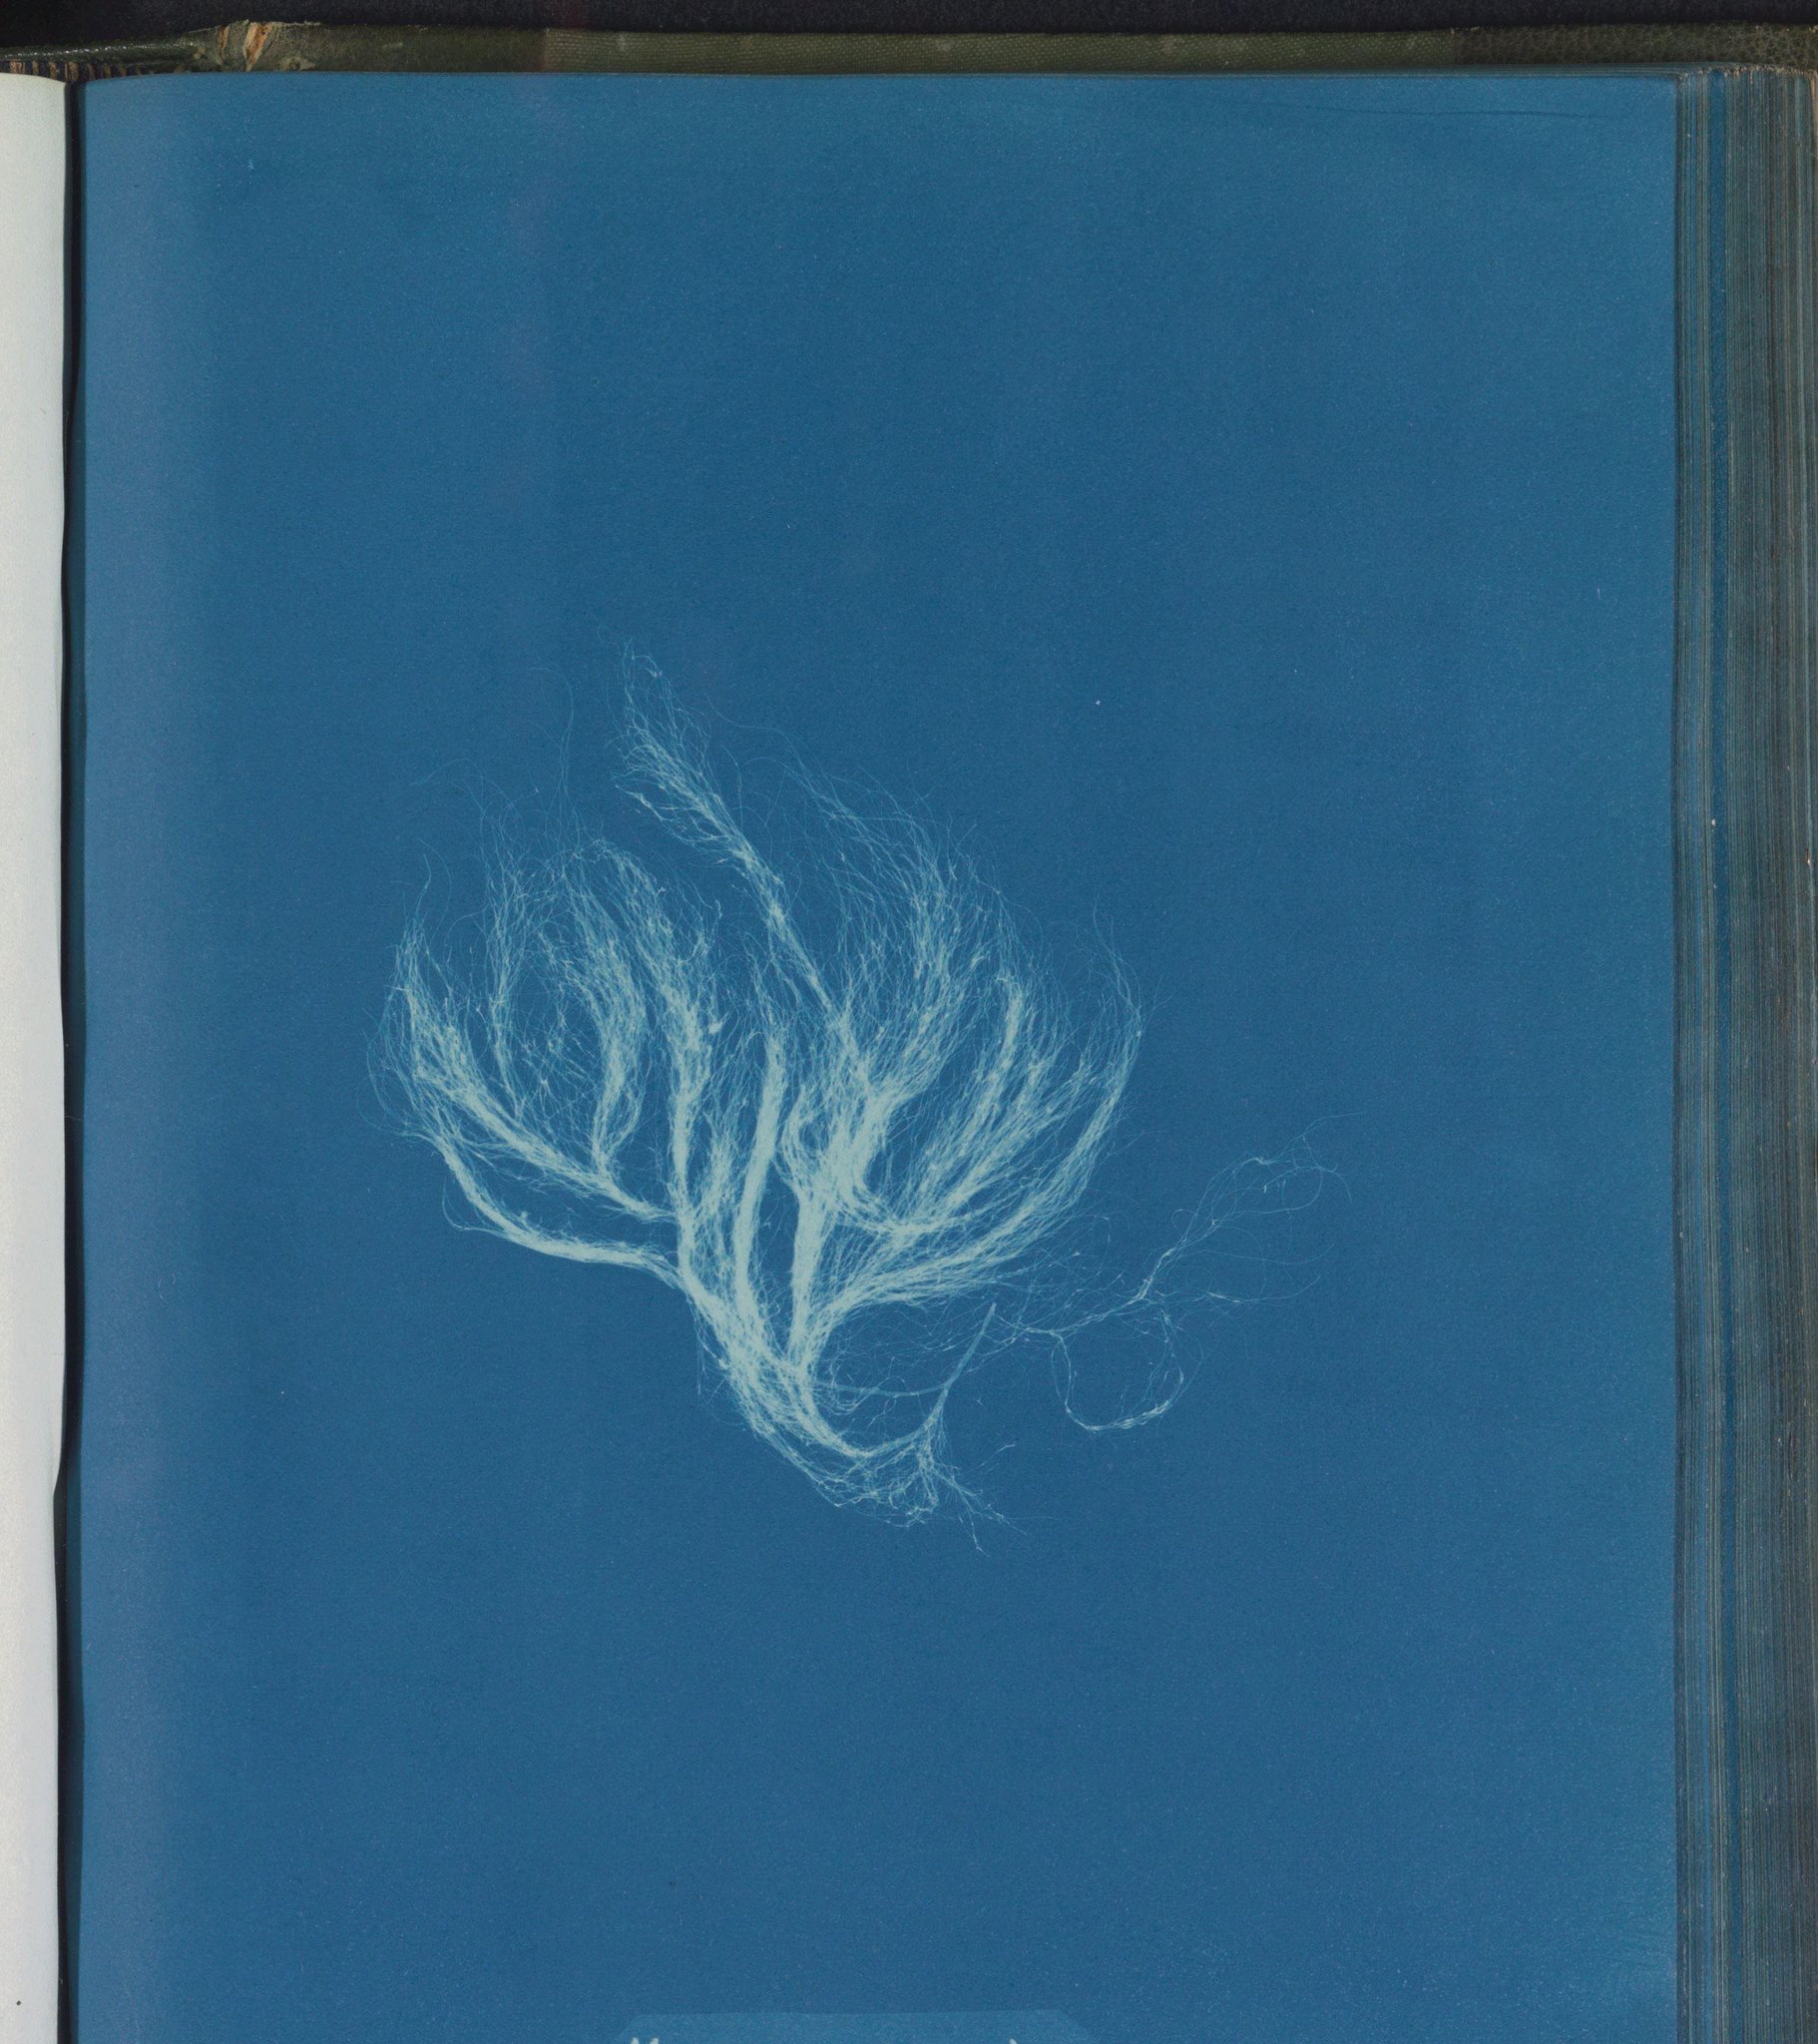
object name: page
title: Myrionema strangulans / parasitic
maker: anna atkins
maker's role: fotograaf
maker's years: 1799-1871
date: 1843-1853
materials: photographic support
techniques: cyanotype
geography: united kingdom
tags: algae, seaweed